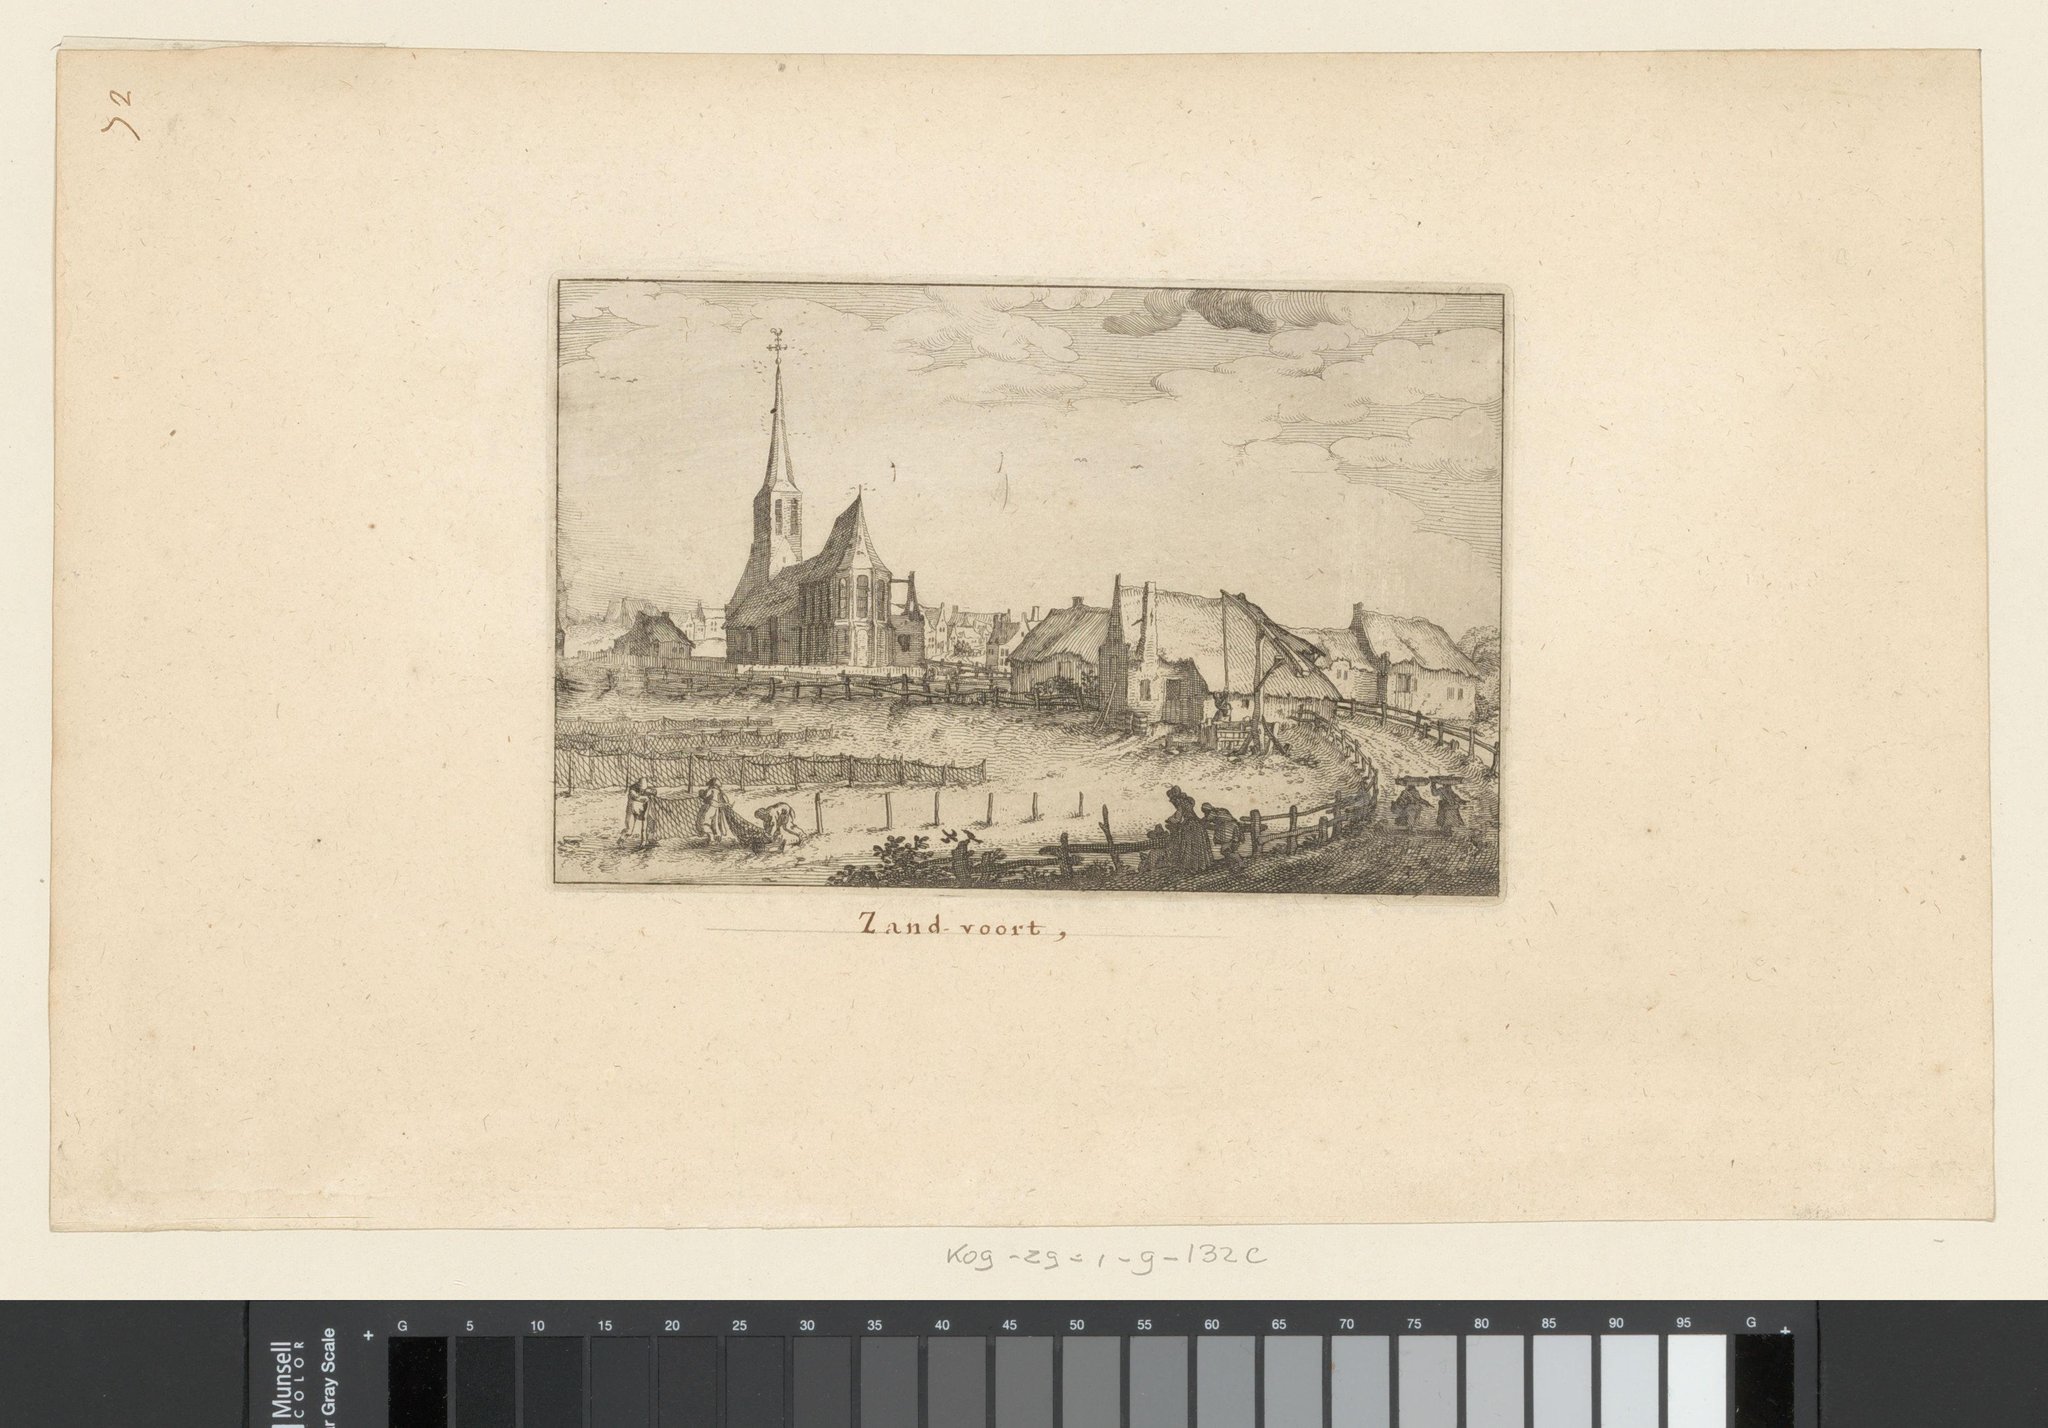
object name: print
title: Sandtvoort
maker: claes jansz. visscher (ii)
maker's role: draughtsman, print maker, publisher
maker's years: 1586-1652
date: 1611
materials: paper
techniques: etching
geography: amsterdam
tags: well, carrying something on the head or on the shoulders, mending of fishing nets, parts of church exterior and annexes: tower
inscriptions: collector's mark: Lugt 1641, stamp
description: Gezicht op Zandvoort aan Zee, met de kerk en enkele lage huisjes. Op de voorgrond worden visnetten uitgezet en iets verder naar achter haalt een vrouw water uit een put. Rechts twee vrouwen met manden op het hoofd. Deze prent maakt deel uit van de serie 'Gezichten bij Haarlem'. Onderwerpsrubrieken binnen de Atlas Zeden en Gewoonten: Handel, nijverheid en verkeer, Buitenleven.